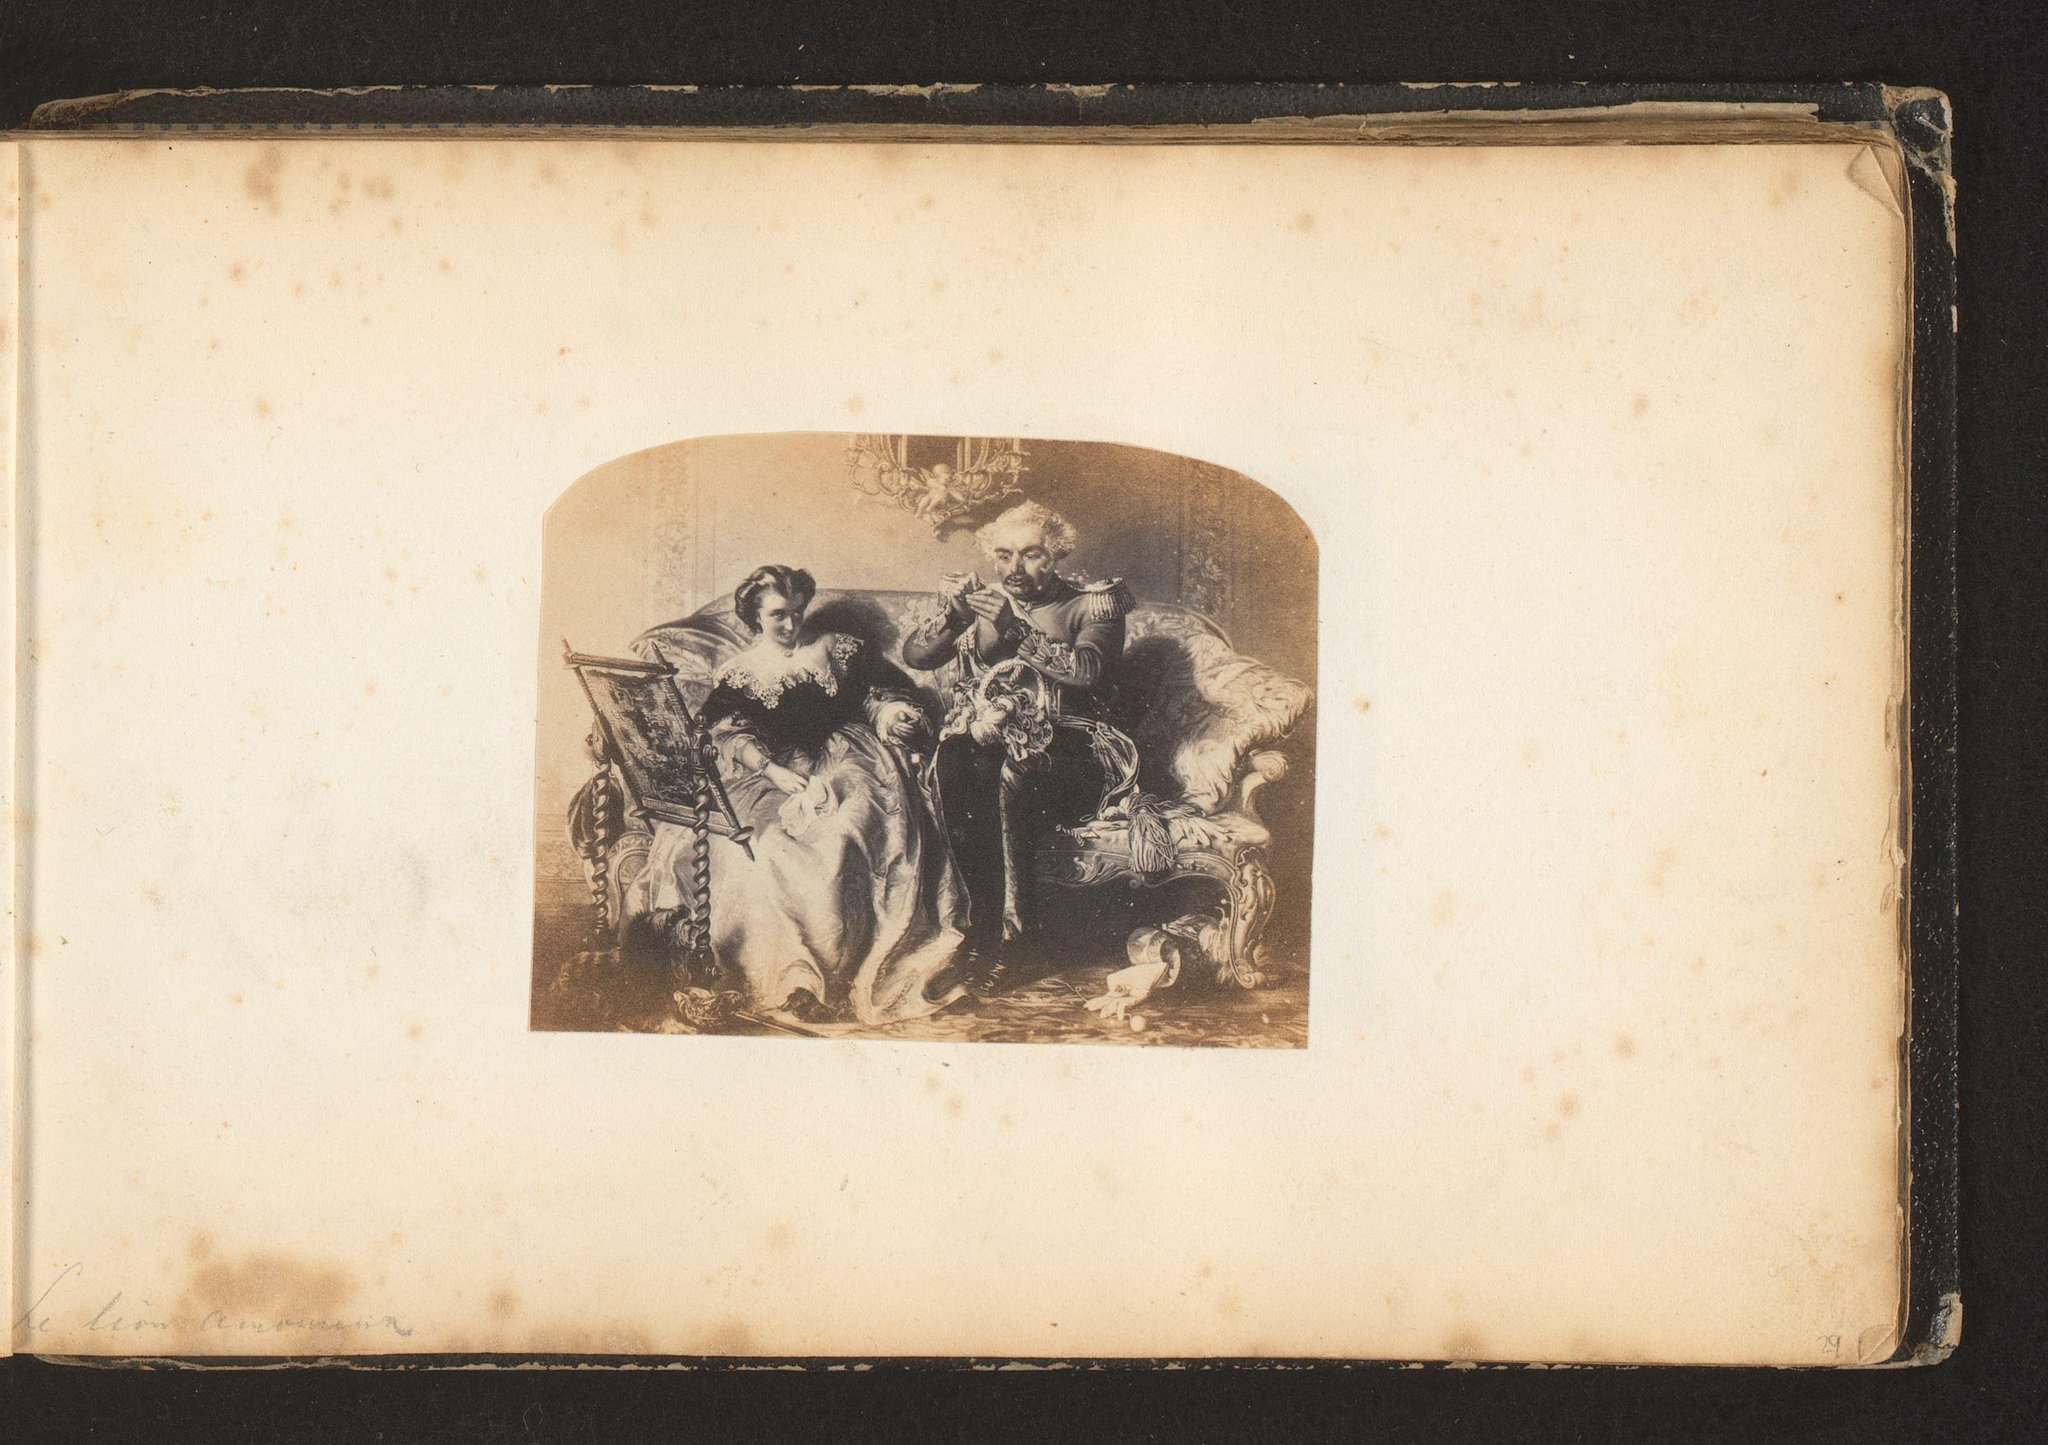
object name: photograph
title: Fotoreproductie van een schilderij van een man in uniform en vrouw, zittend op de bank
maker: Anonymous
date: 1860-1900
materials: photographic support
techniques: albumen print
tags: adult woman, adult man, (military) uniforms, couch, sofa, settee, painting, drawing and the graphic arts